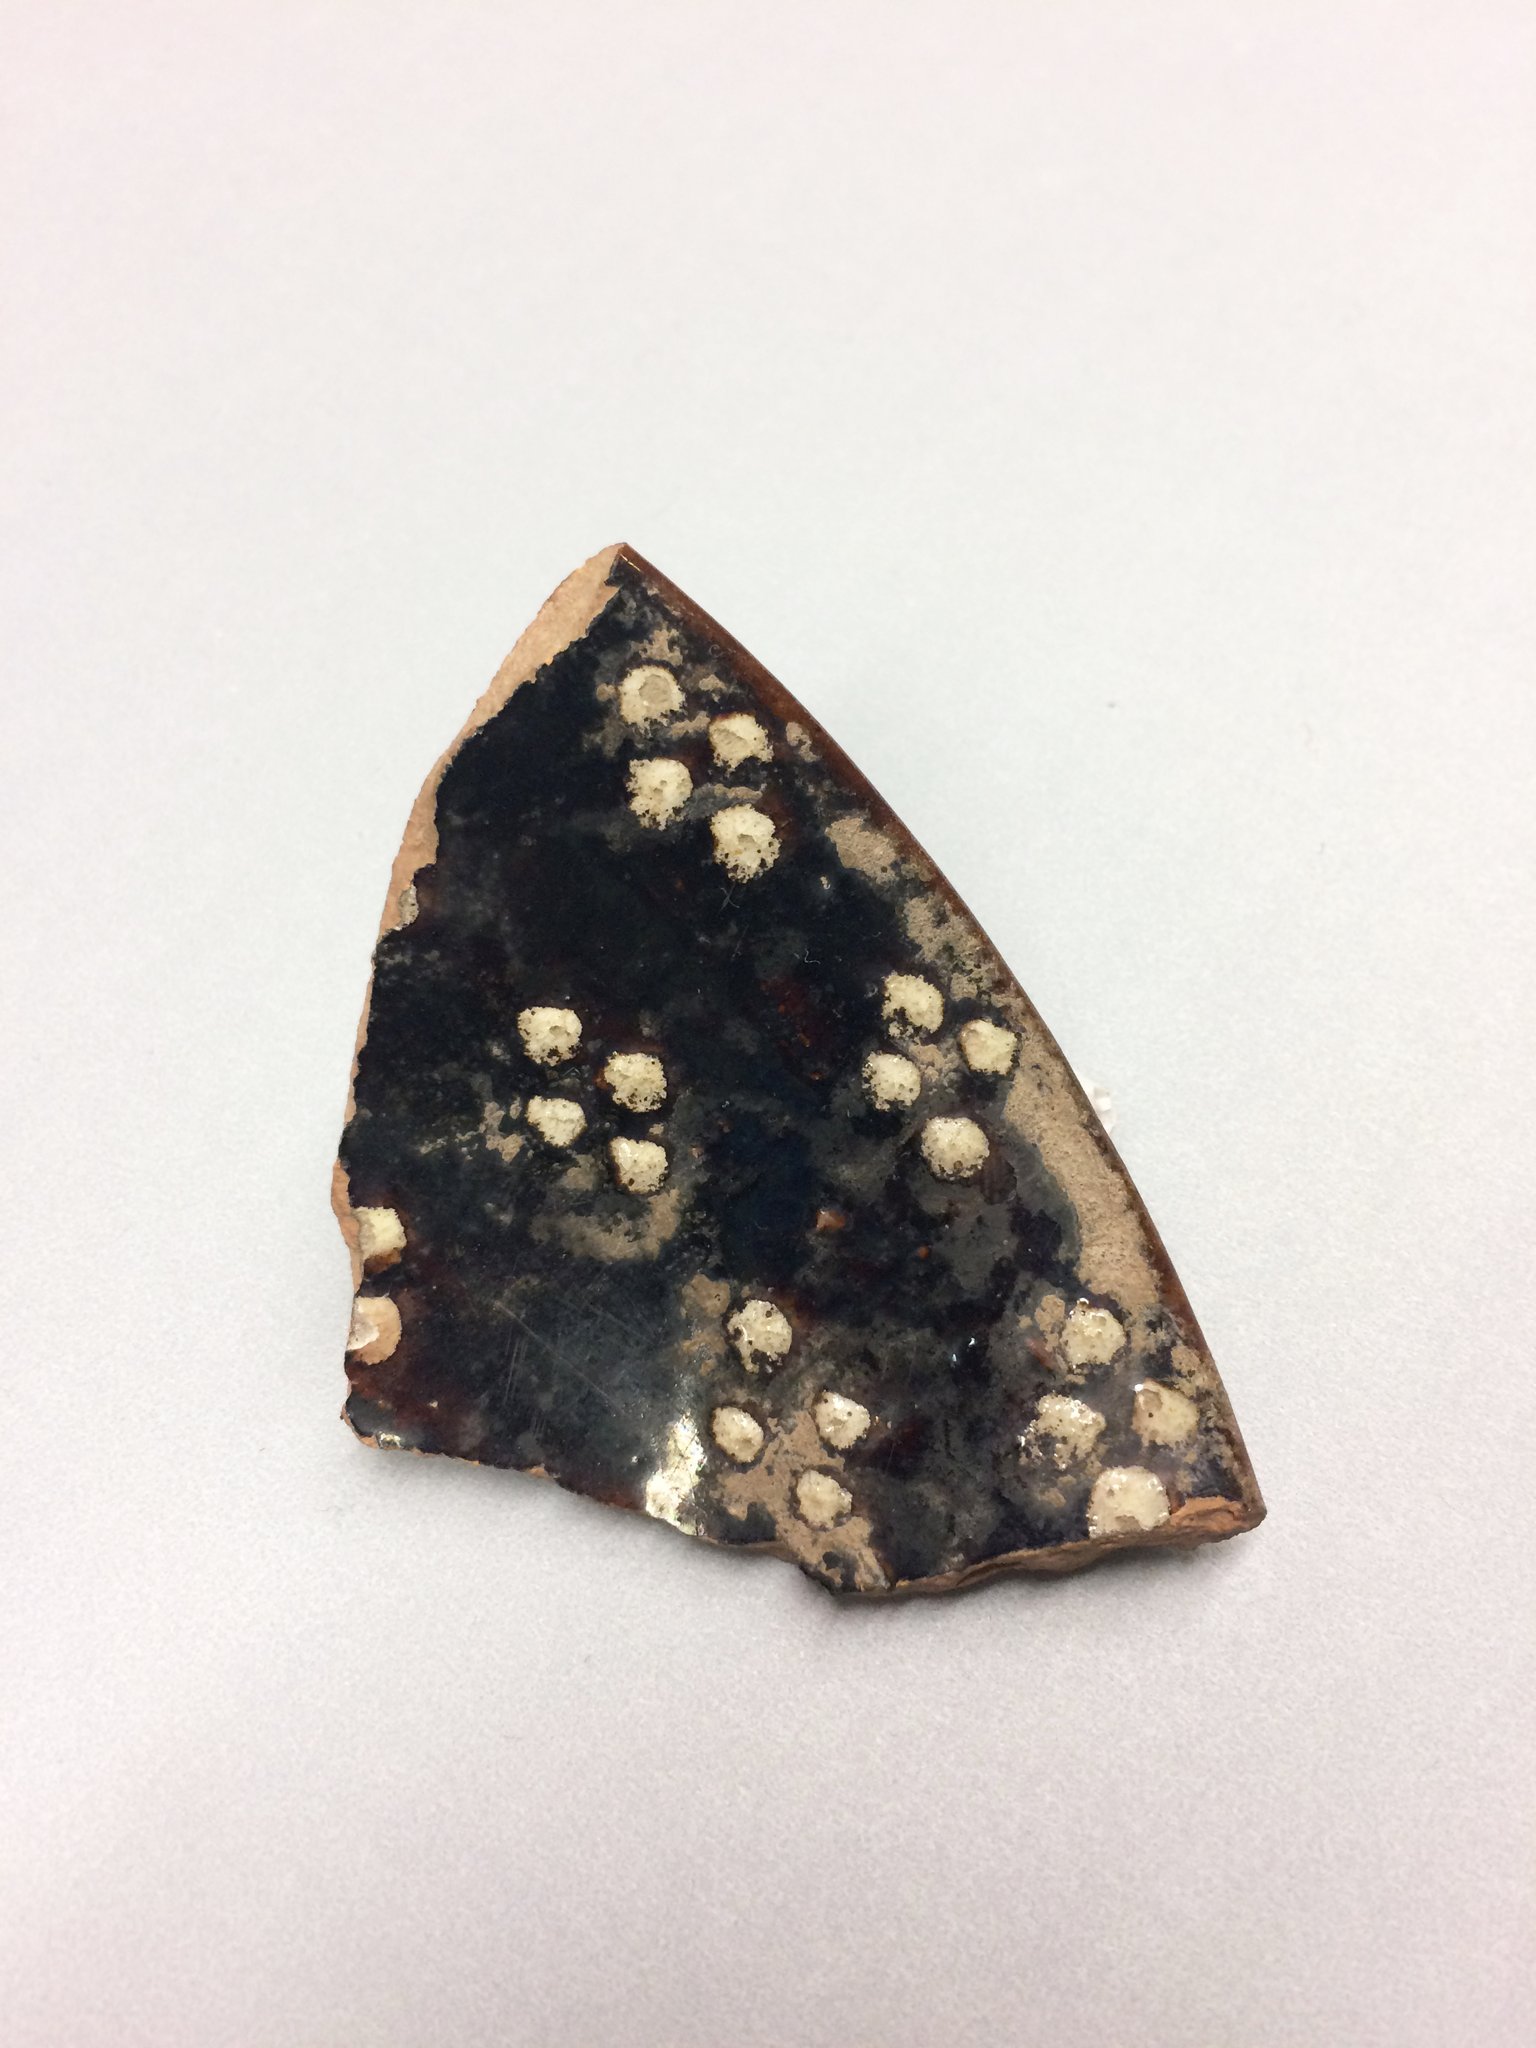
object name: fragment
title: Ceramic Fragment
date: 801-1000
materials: earthenware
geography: iran